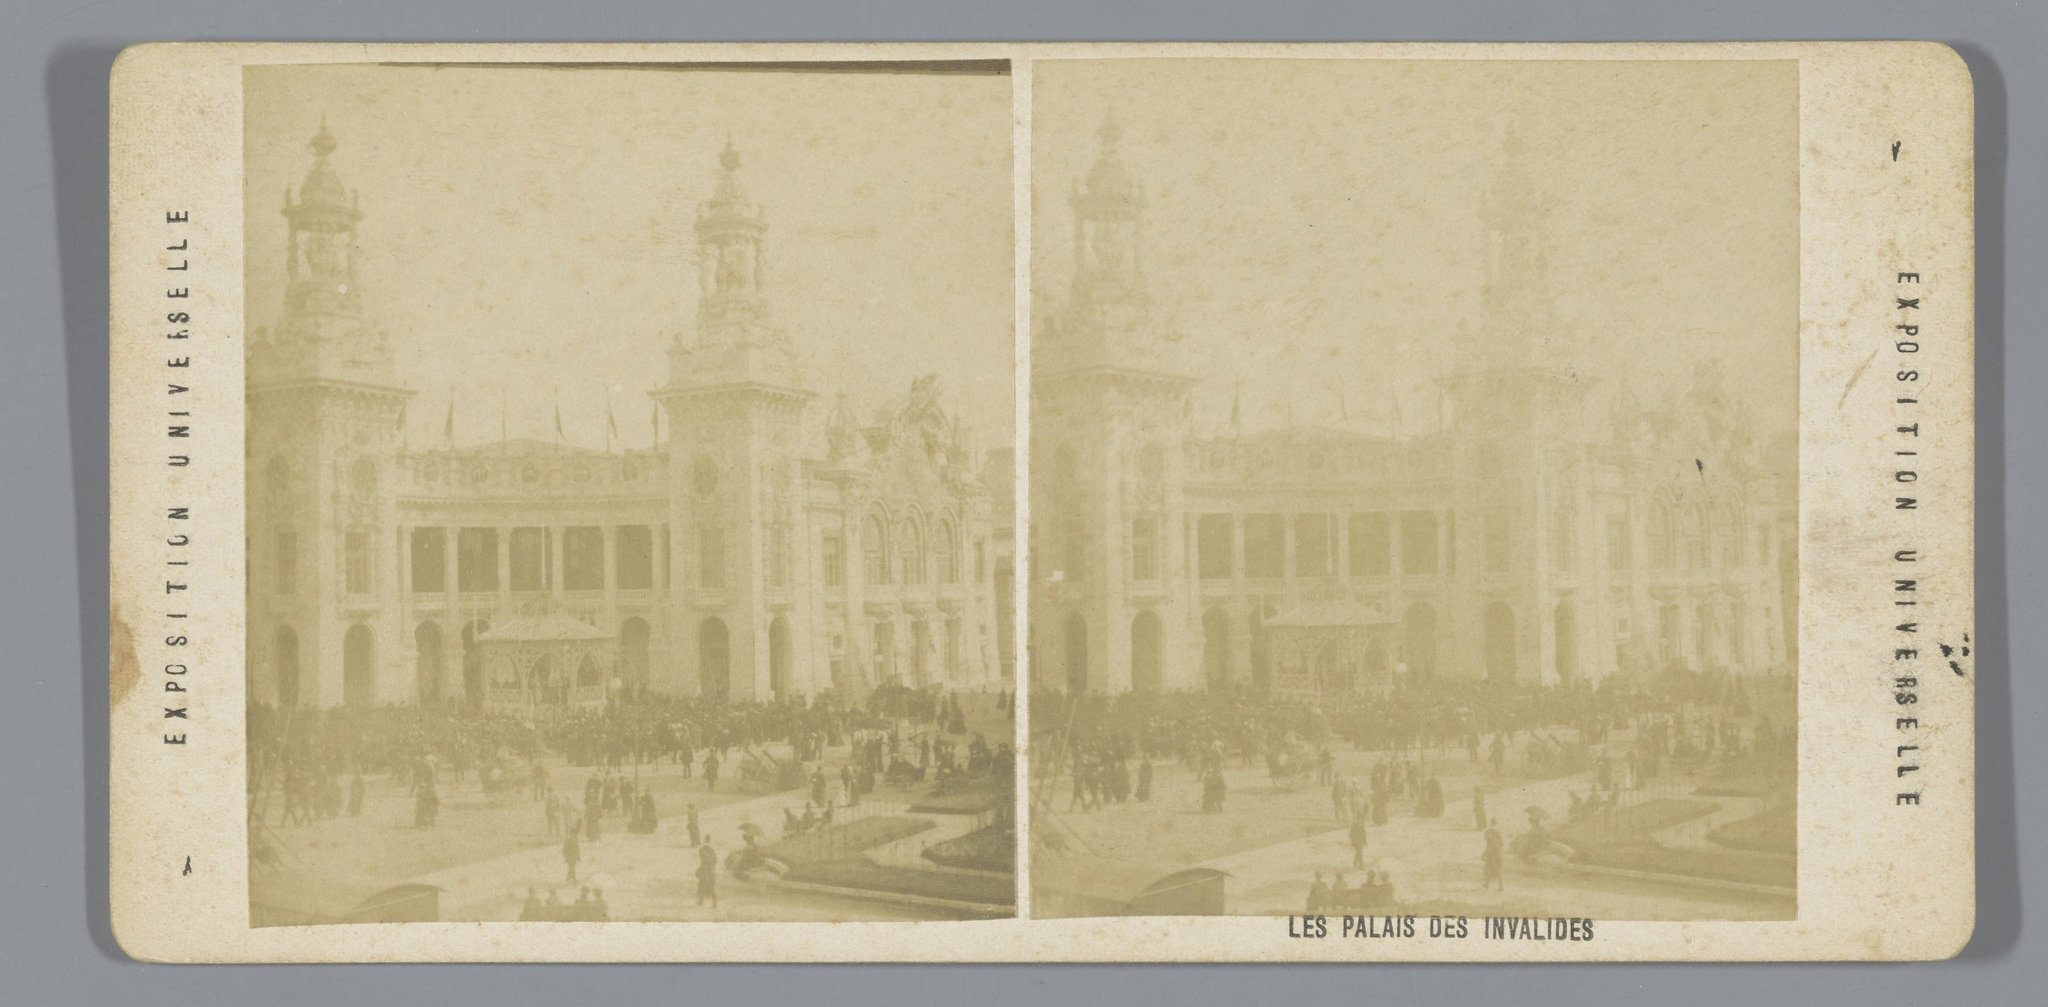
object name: stereograph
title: Palais des Invalides tijdens de Wereldtentoonstelling van 1900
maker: Anonymous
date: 1900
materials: cardboard, paper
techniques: albumen print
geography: paris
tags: world fair, world exhibition, palace, paris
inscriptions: inscription: ‘Parijs 1900’